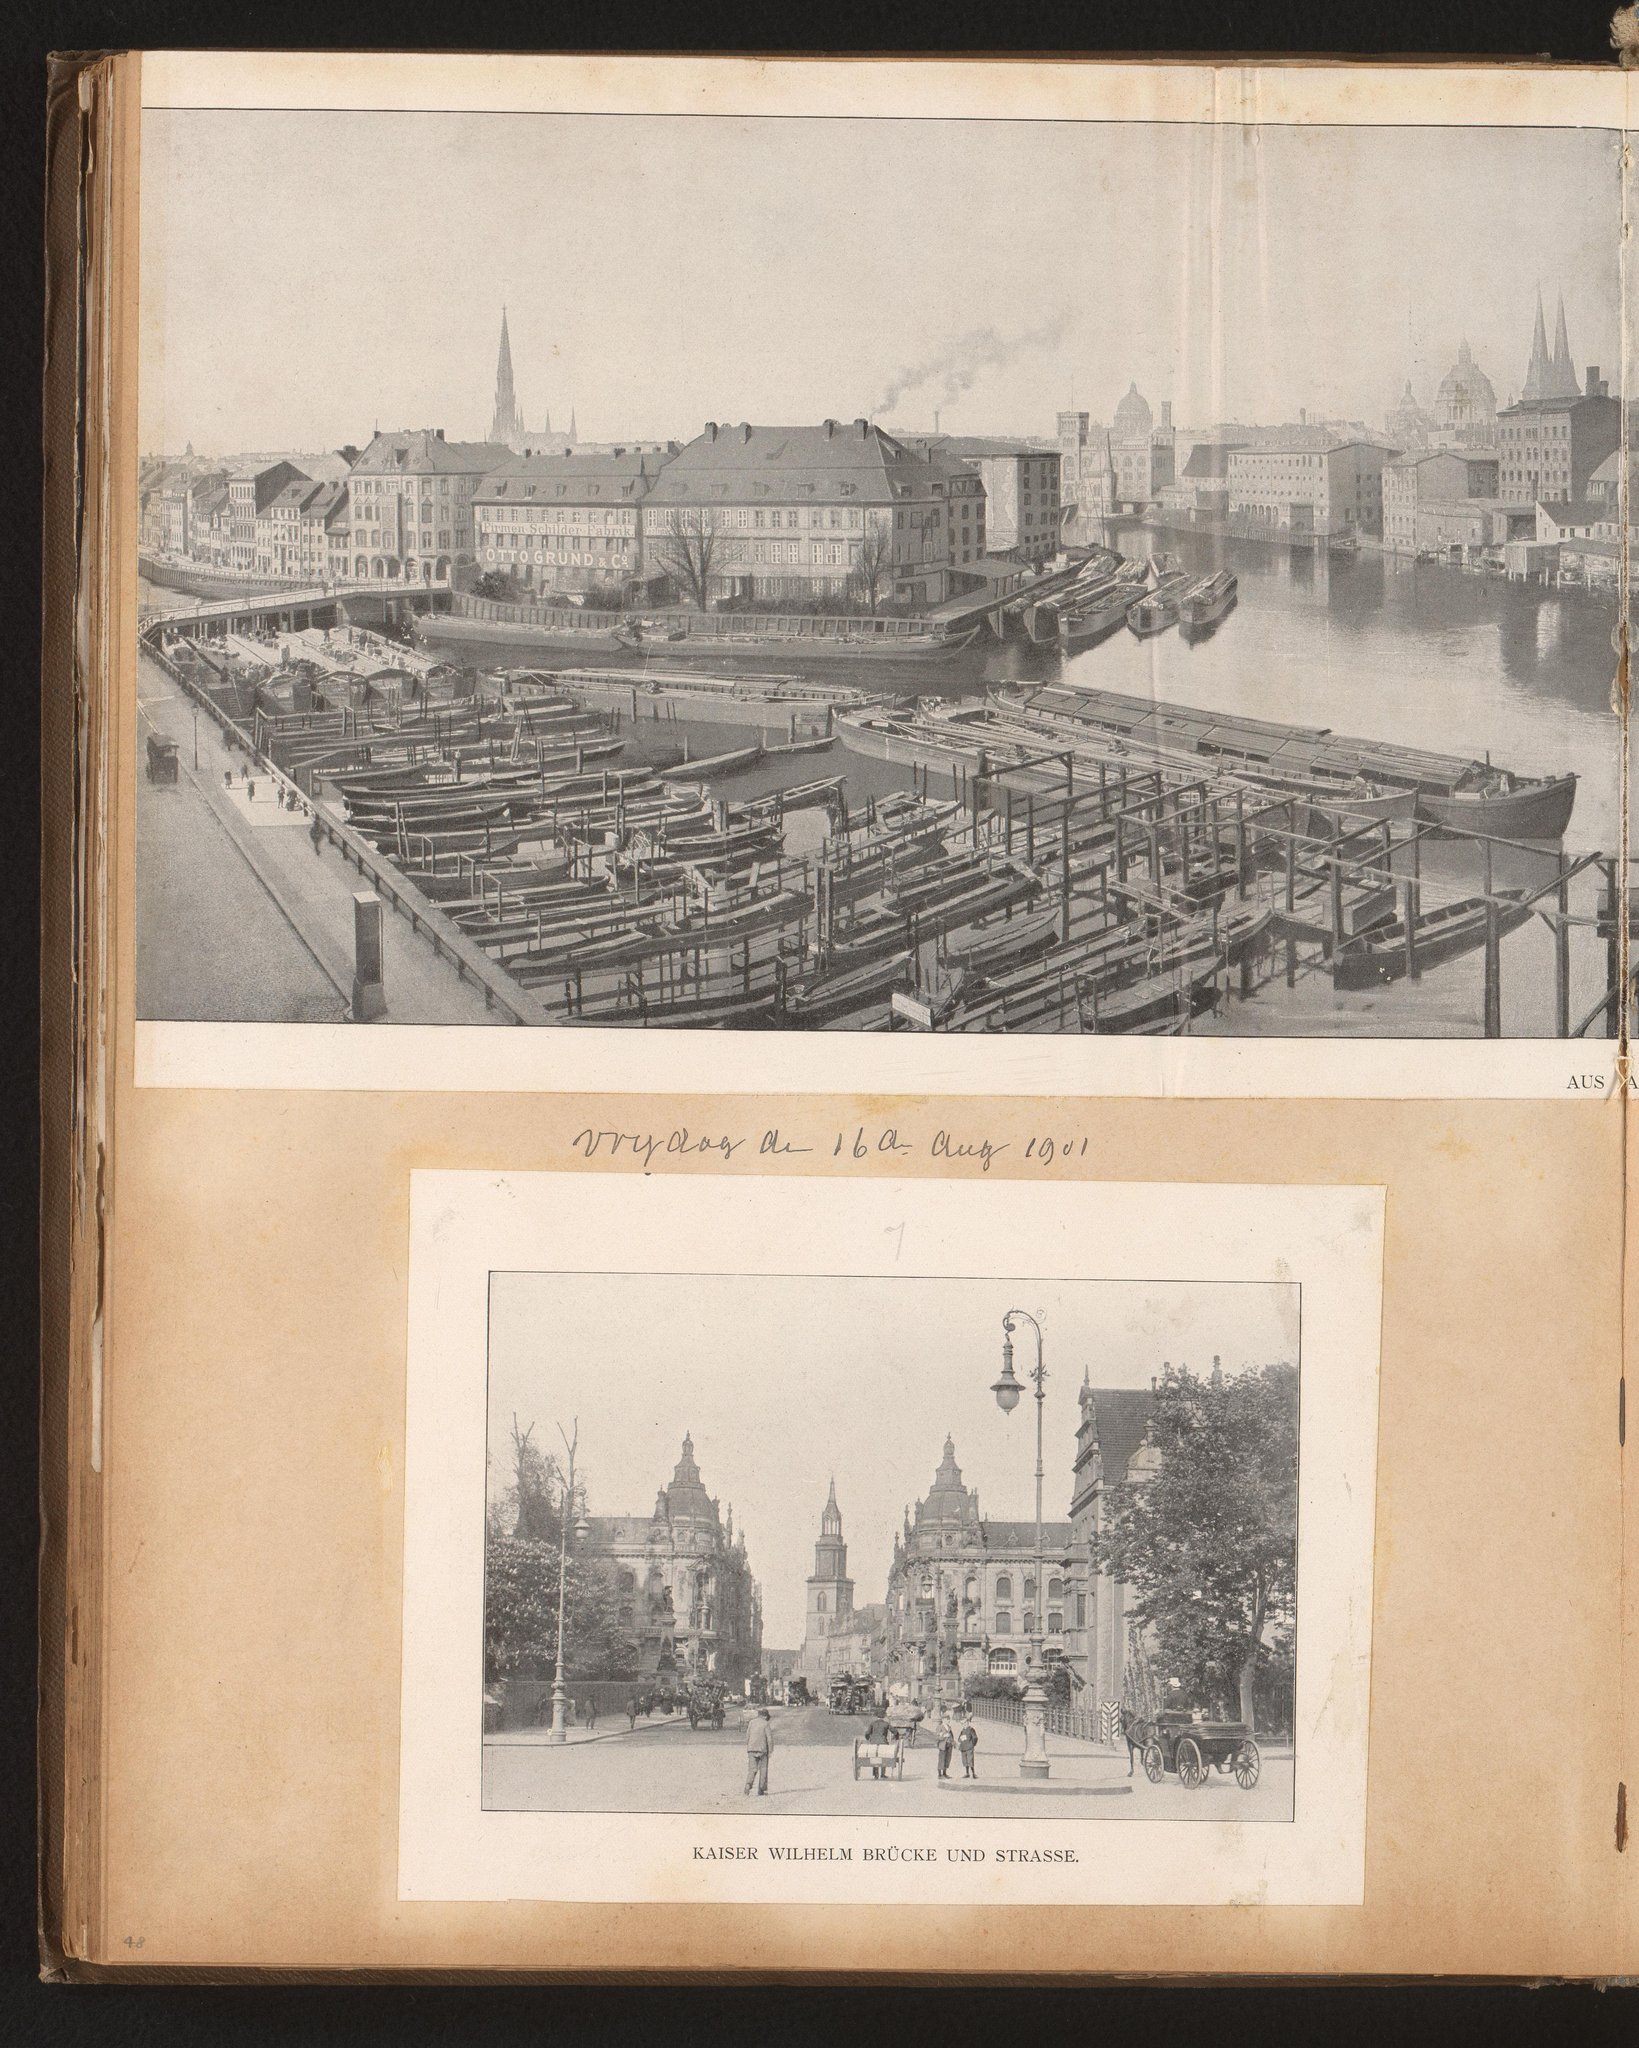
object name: album leaf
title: Panorama over de Spree vanaf de haven richting het noorden, en de Kaiser-Wilhelm-Brücke, Berlijn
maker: Anonymous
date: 1896-1901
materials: paper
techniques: autotype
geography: berlin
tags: harbour, city-view in general; 'veduta', river, street, berlin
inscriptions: title: ‘Kaiser Wilhelm Brücke und Strasse.’, inscription: ‘Vrijdag den 16de Aug 1901’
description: De bovenste prent op deze pagina loopt door op de volgende pagina; zie RP-F-2003-40-49.